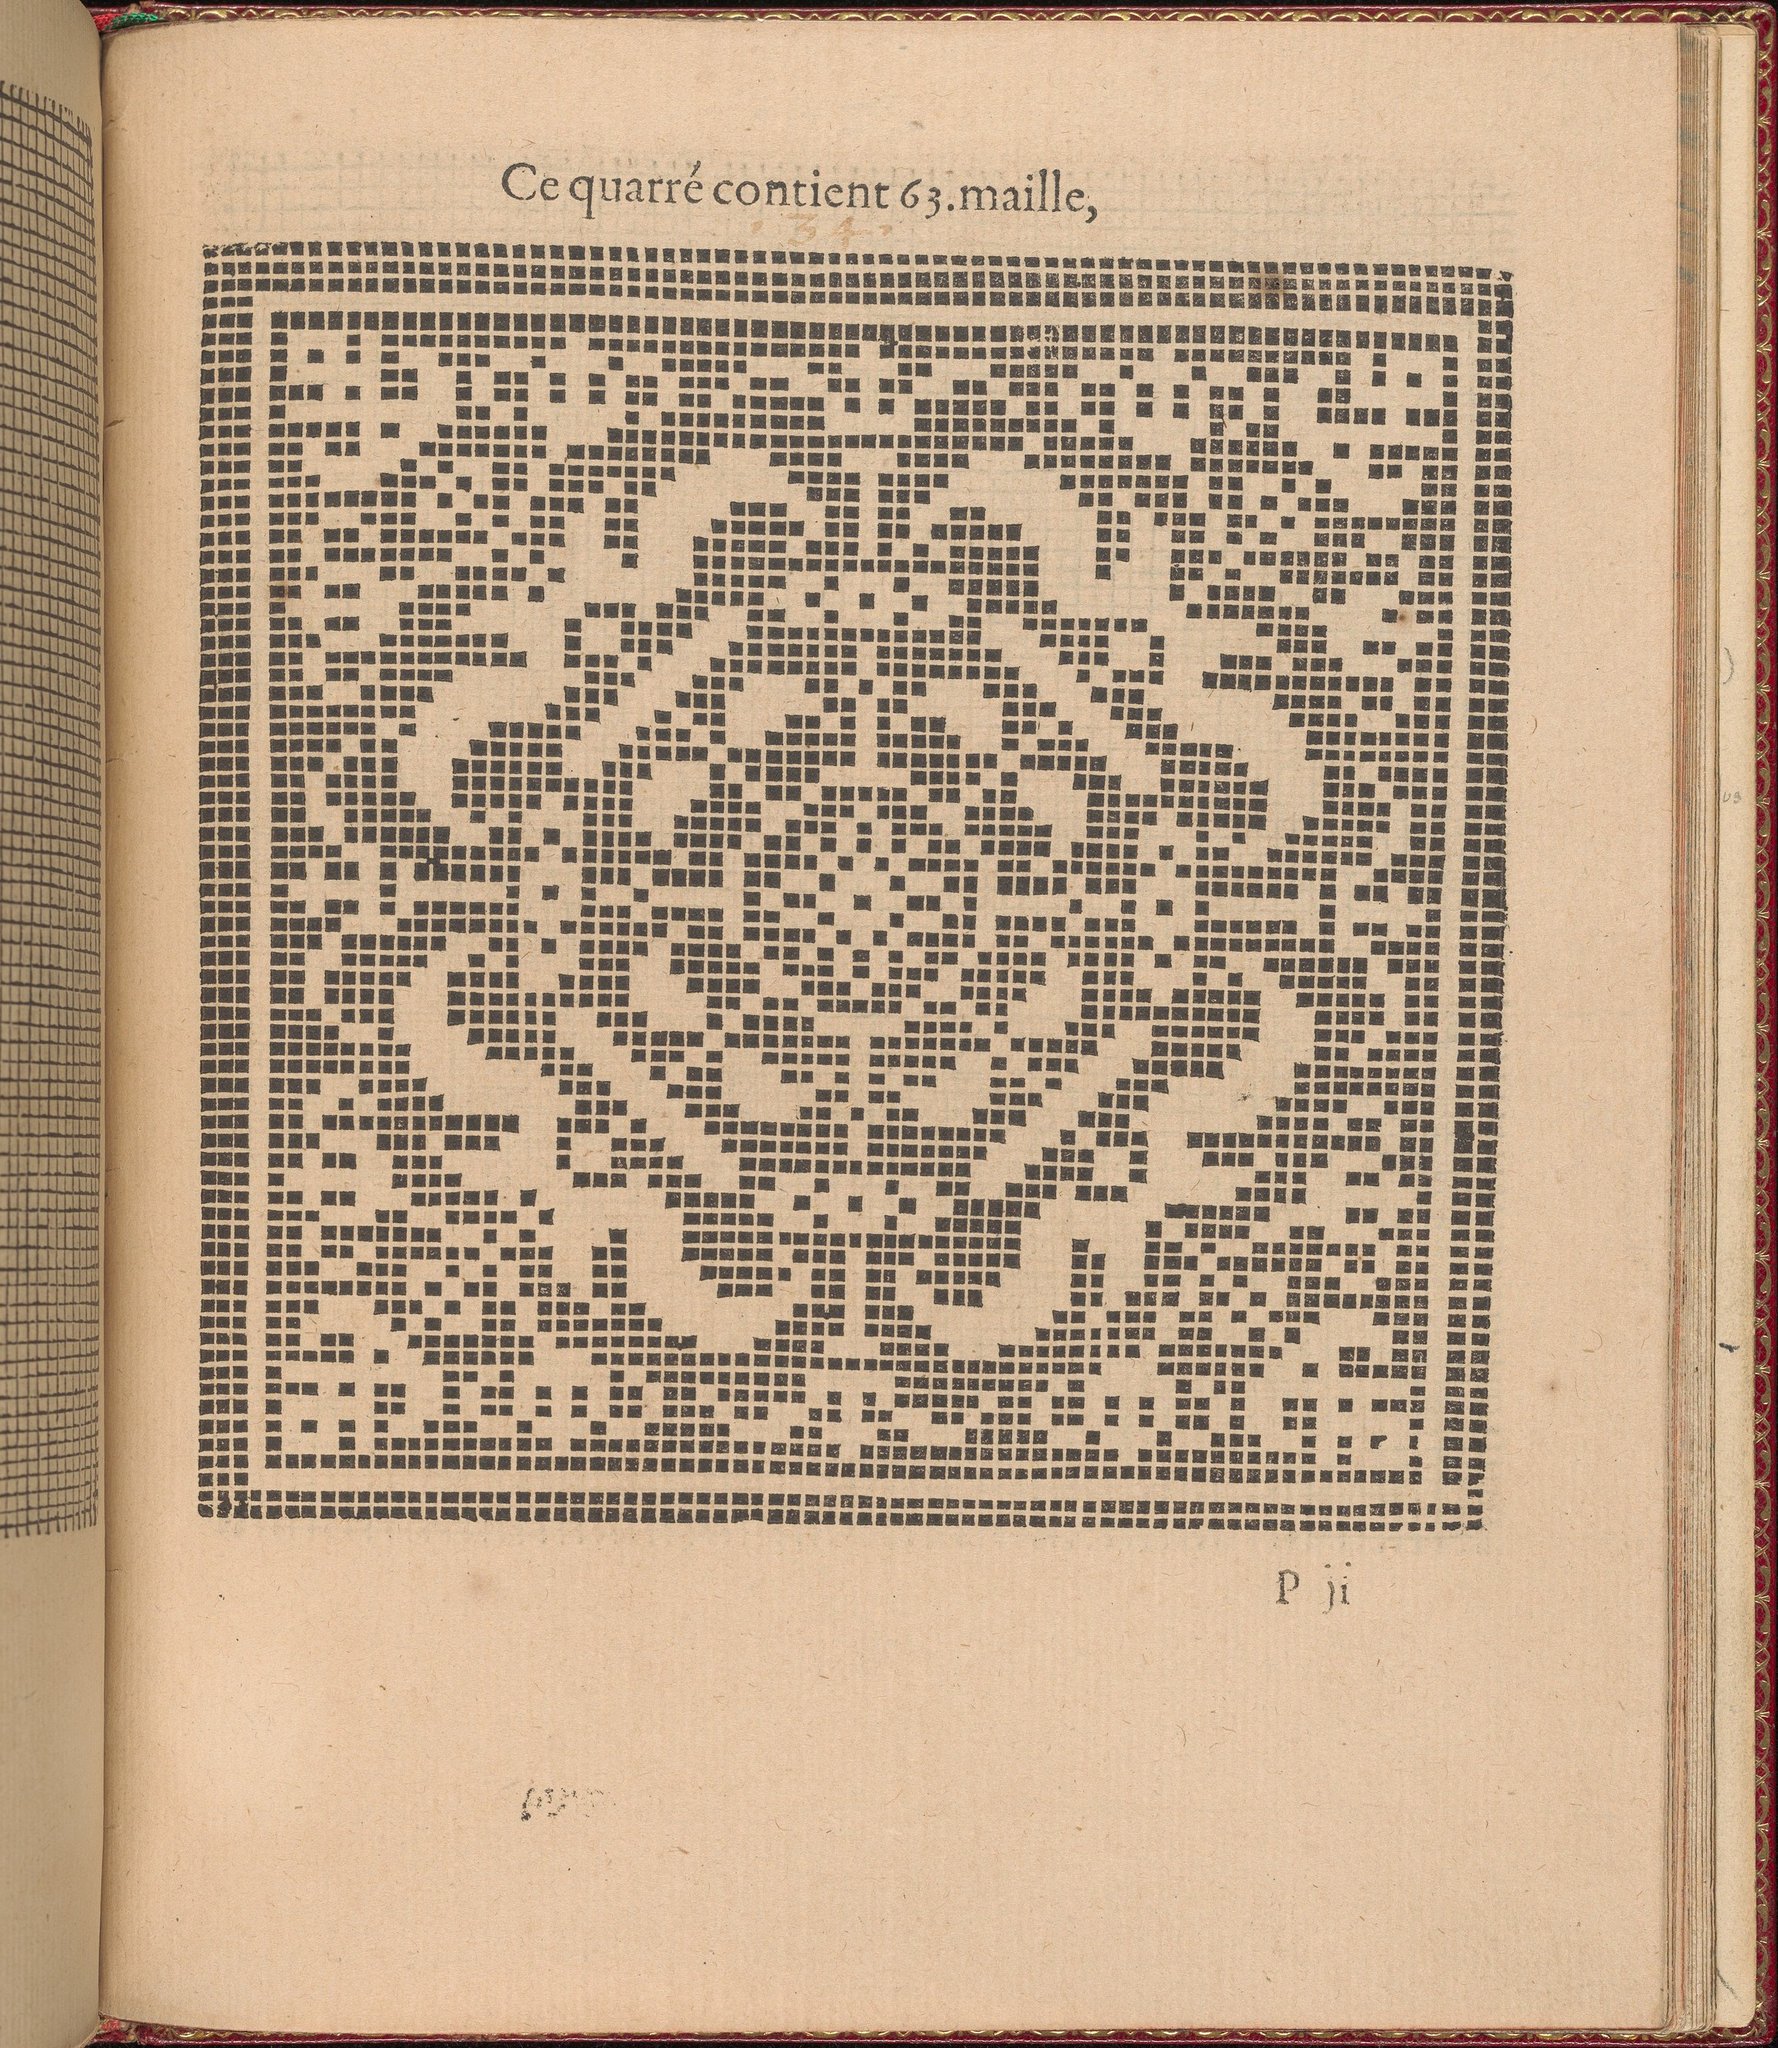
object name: book print ornament architecture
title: Les Singuliers et Nouveaux Portraicts... page 58 (recto)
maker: federico de vinciolo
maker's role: designer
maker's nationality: italian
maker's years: 1582-1599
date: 1588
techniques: woodcut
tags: flowers